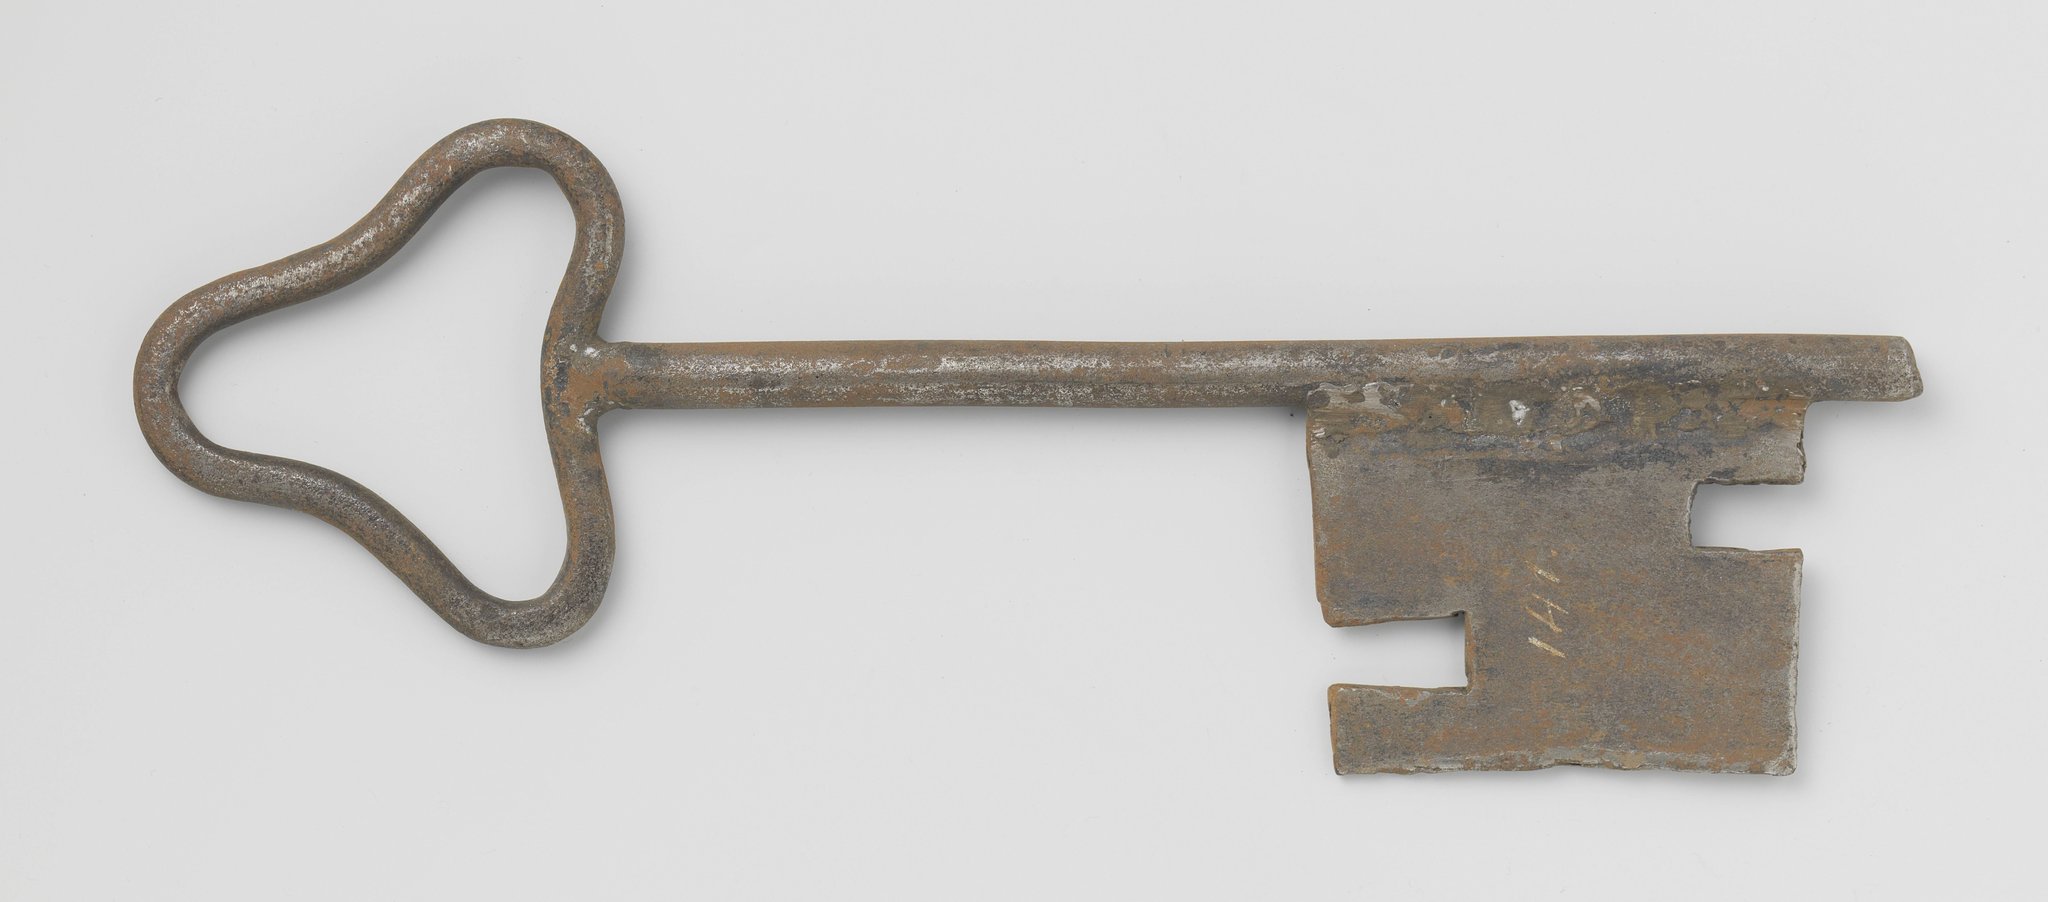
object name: key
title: Sleutel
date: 1400-1950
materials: iron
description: Sleutel waarvan het oog bestaat uit een driehoek met ronde hoeken. De vierkante baard heeft onder en boven een inkeping.